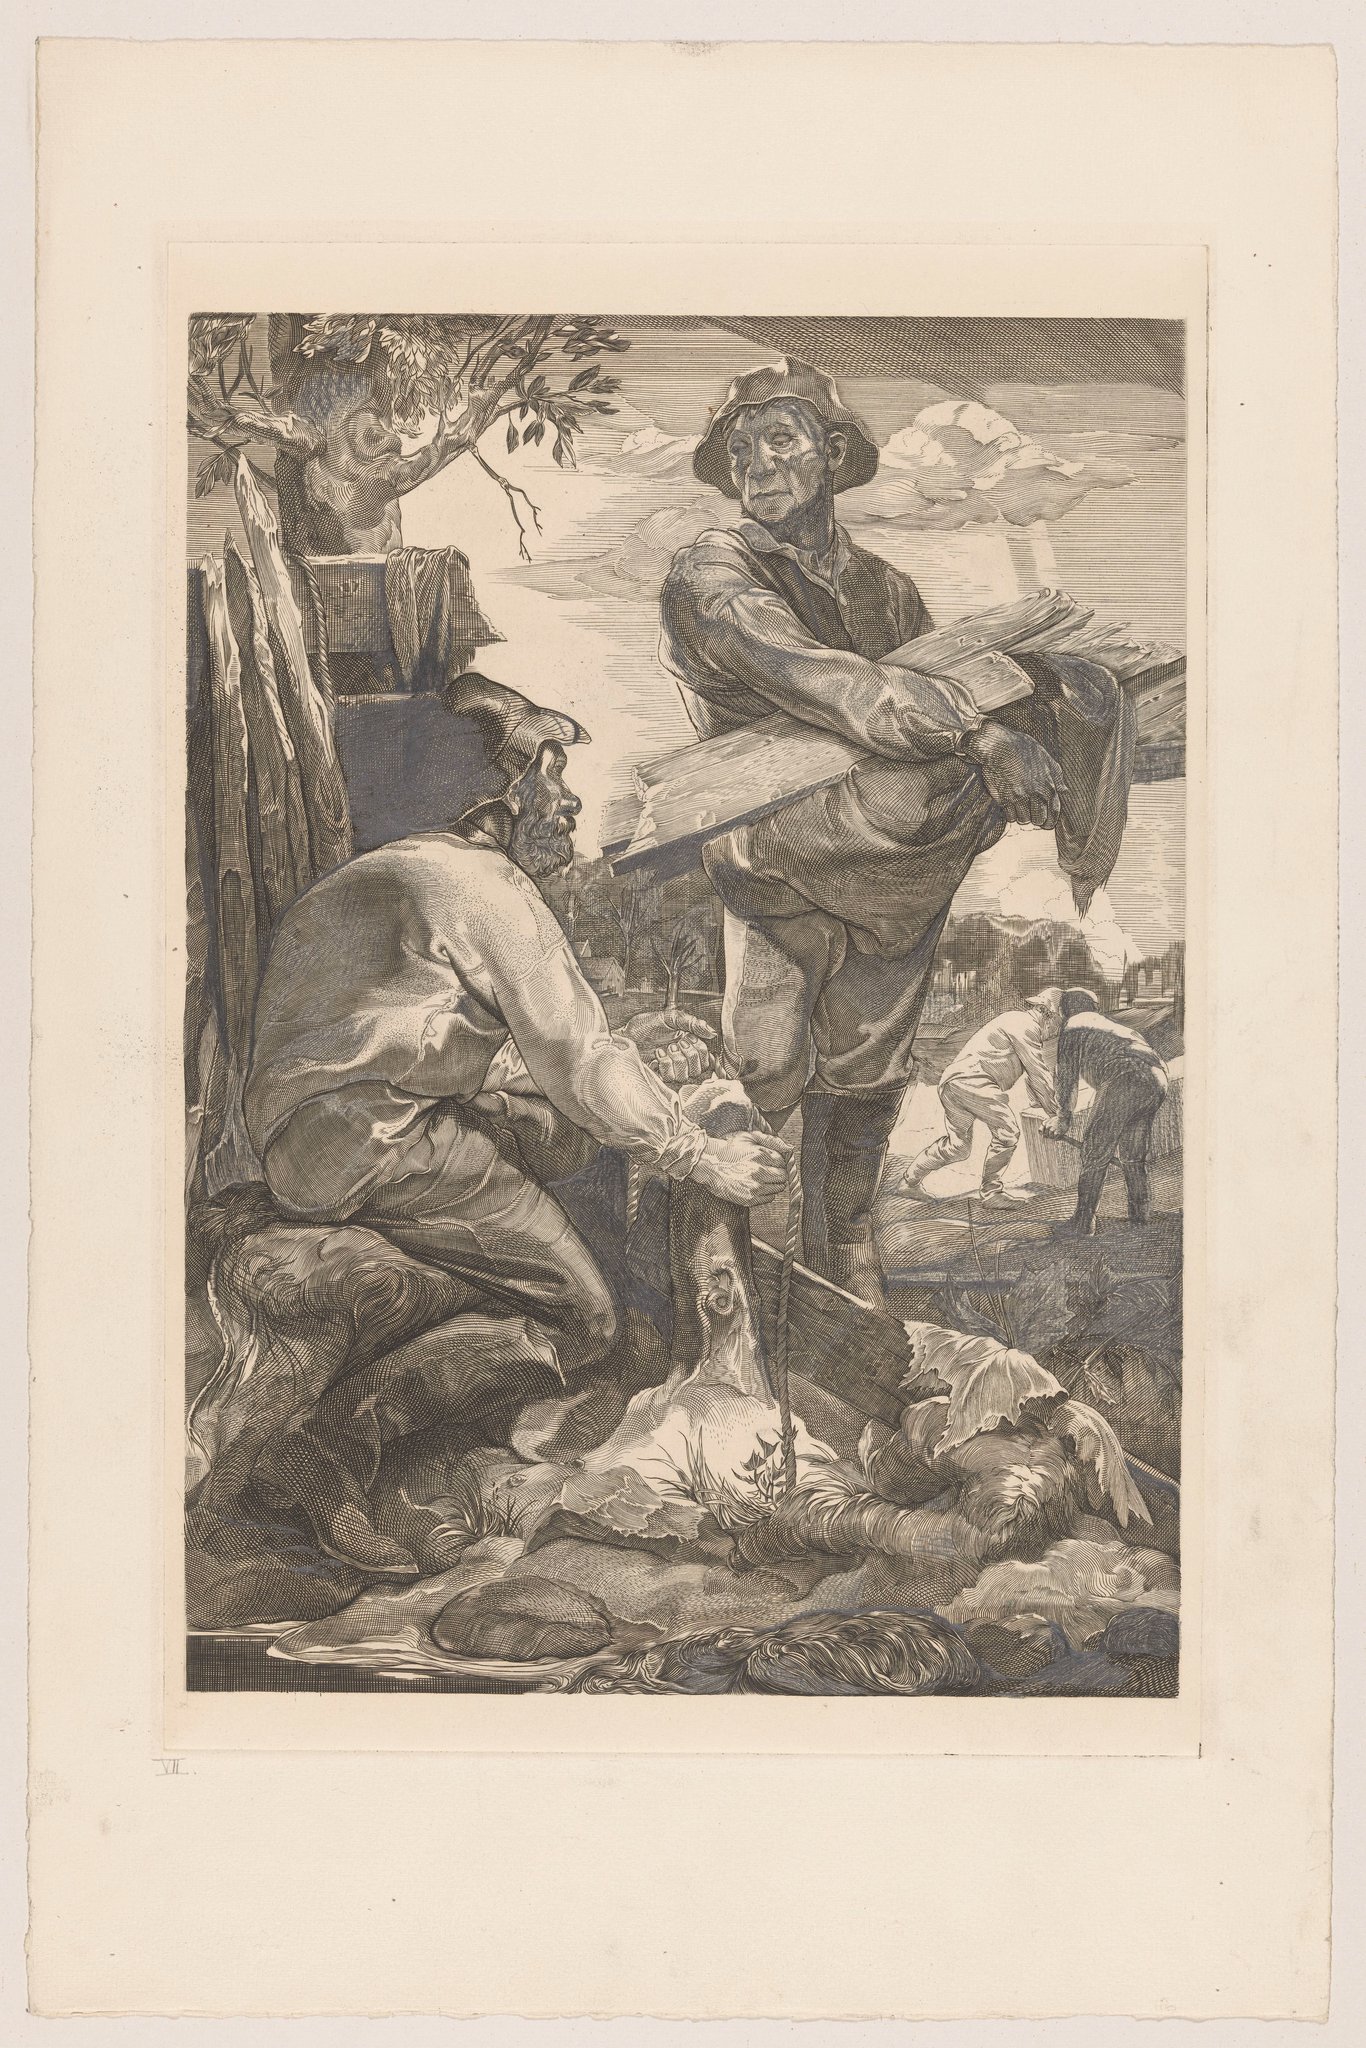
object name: print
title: Twee arbeiders met touw en planken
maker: johannes josephus aarts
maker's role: draughtsman, print maker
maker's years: 1871-1934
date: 1881-1934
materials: chalk, paper, pencil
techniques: engraving, intaglio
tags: plank, board ~ building material, working class, labourers, tools, aids, implements ~ crafts and industries: rope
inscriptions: collector's mark: Lugt 2166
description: Twee arbeiders met hoed, waarvan één zittend en de ander staand. De zittende man bindt een touw om een boomstam. De staande man houdt een stapel afbraakhout vast. Op de achtergrond wrikken twee arbeiders met een staaf onder een rechthoekig object. Op deze zevende staat van de gravure is het gezicht van de zittende man vervangen.